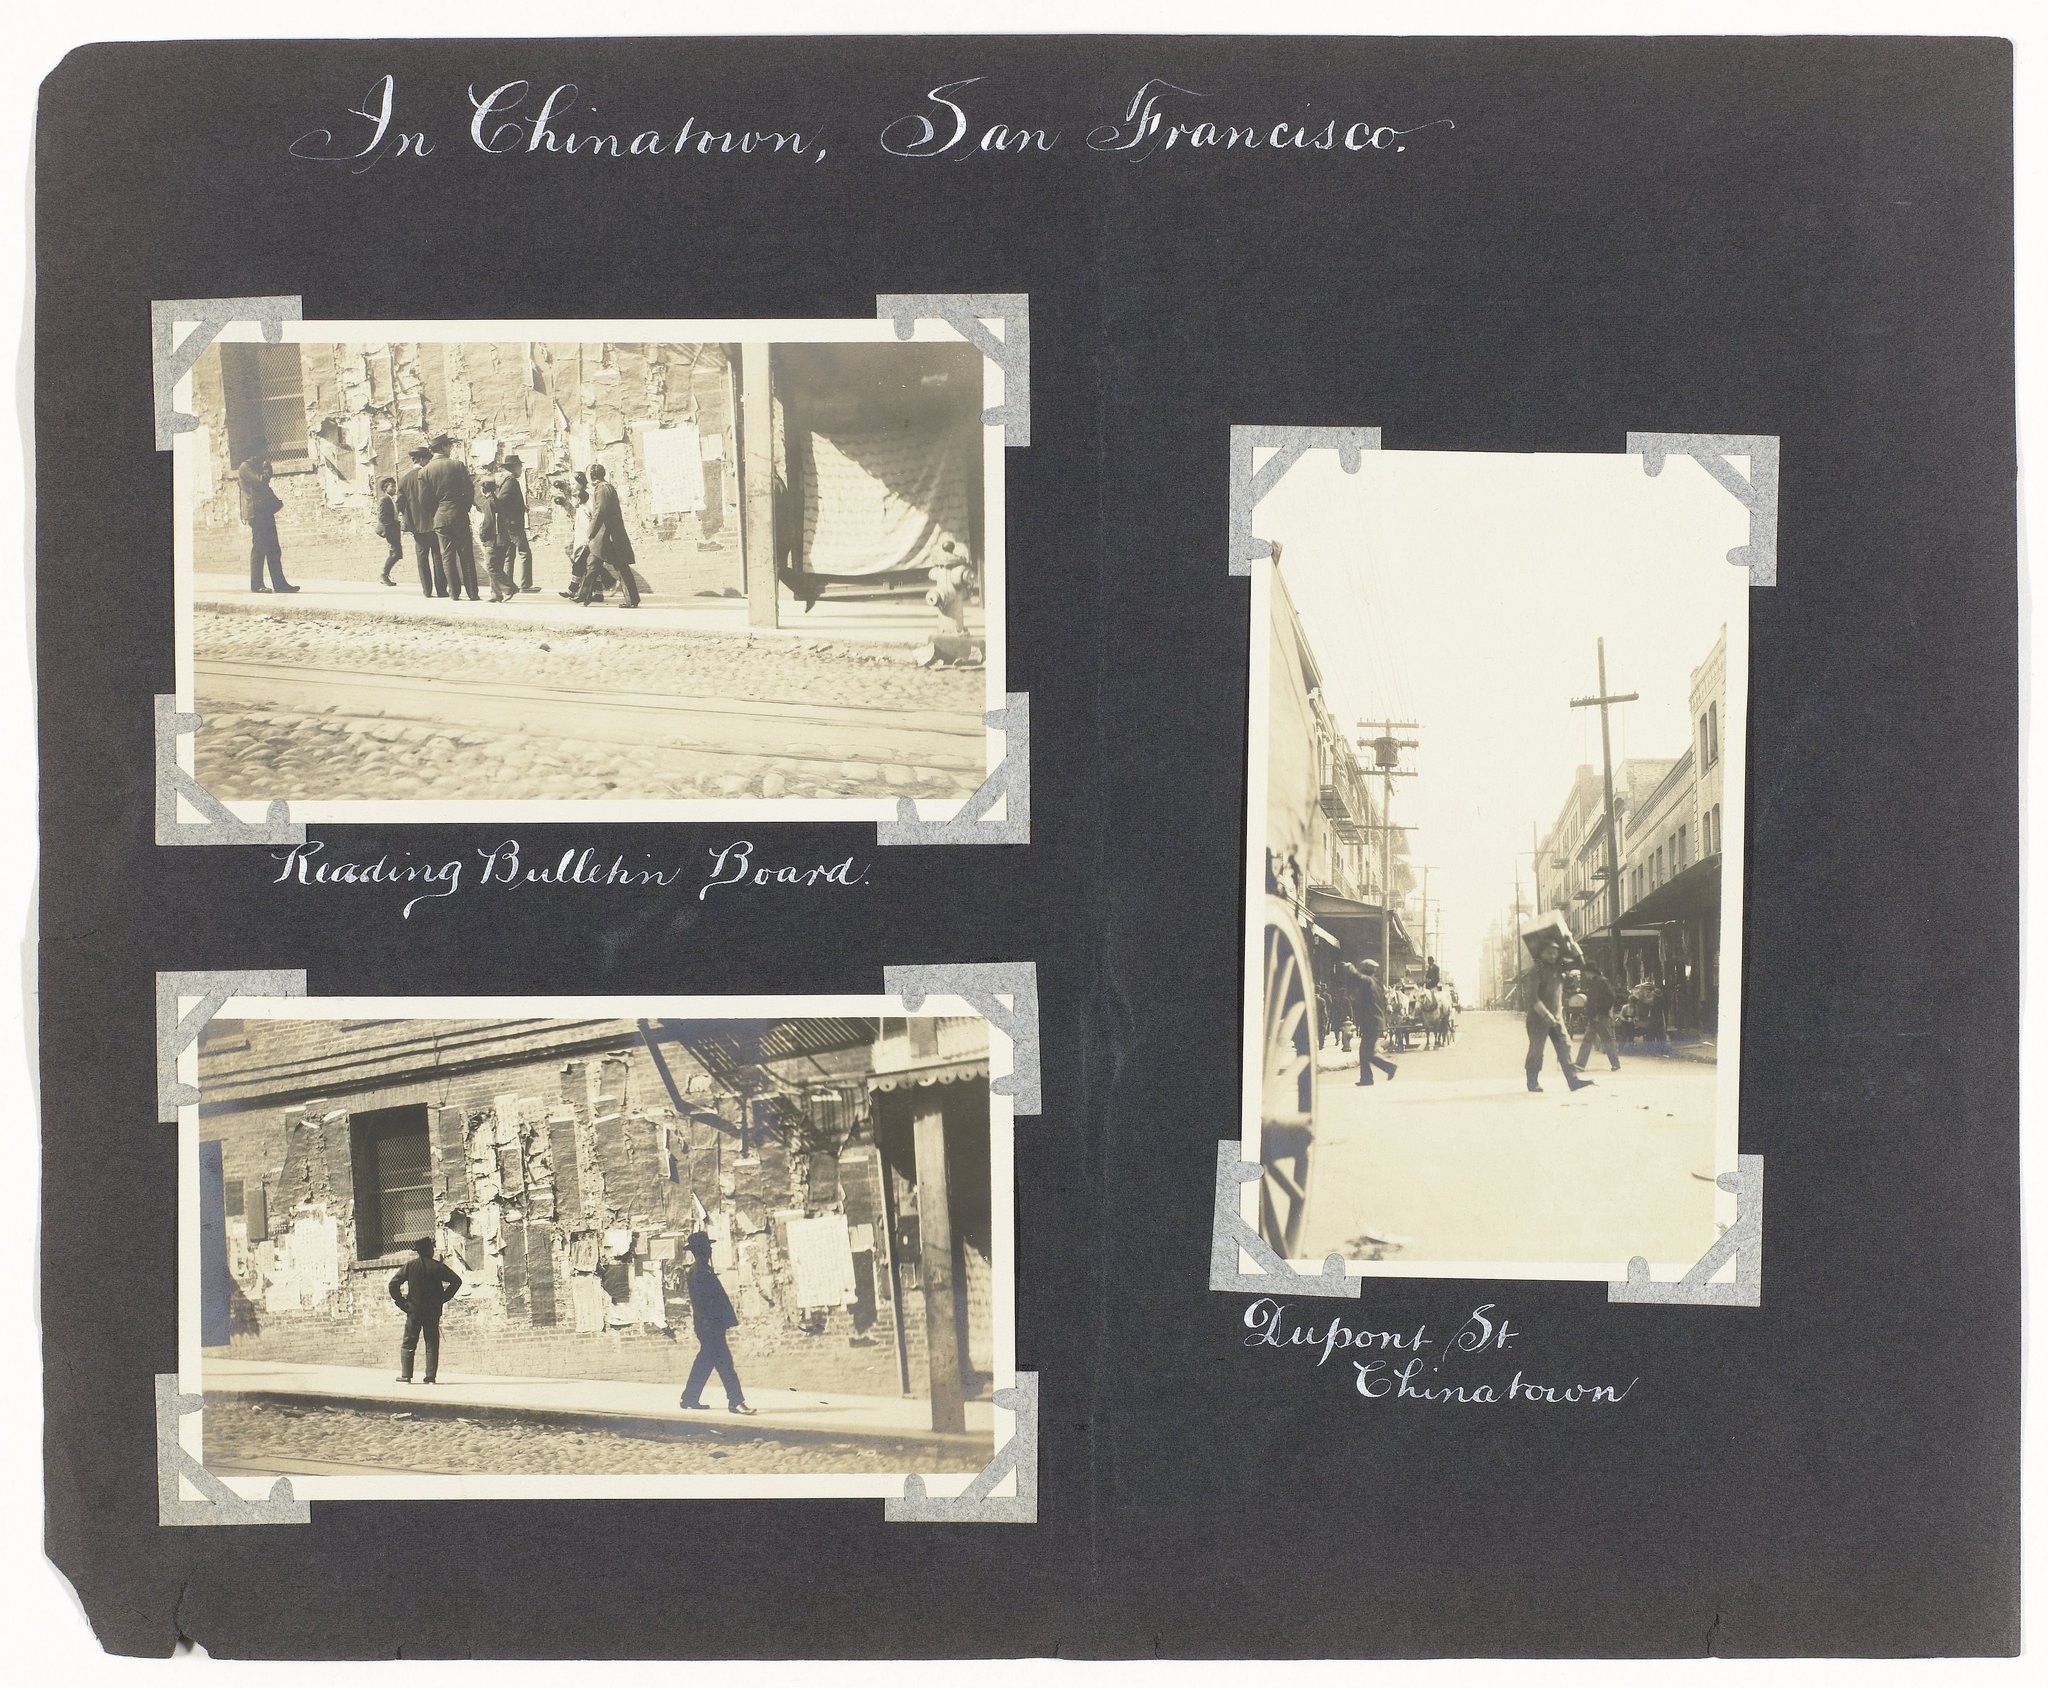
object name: photograph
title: Drie straatgezichten in Chinatown, San Francisco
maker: Anonymous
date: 1900-1906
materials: paper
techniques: gelatin silver print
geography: san francisco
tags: street (+ city(-scape) with figures, staffage)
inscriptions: inscription: ‘Reading Bulletin Board.’, inscription: ‘Dupont St./ Chinatown’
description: Twee opnamen van het Bulletin Board en een van Dupont Street in Chinatown, San Francisco.